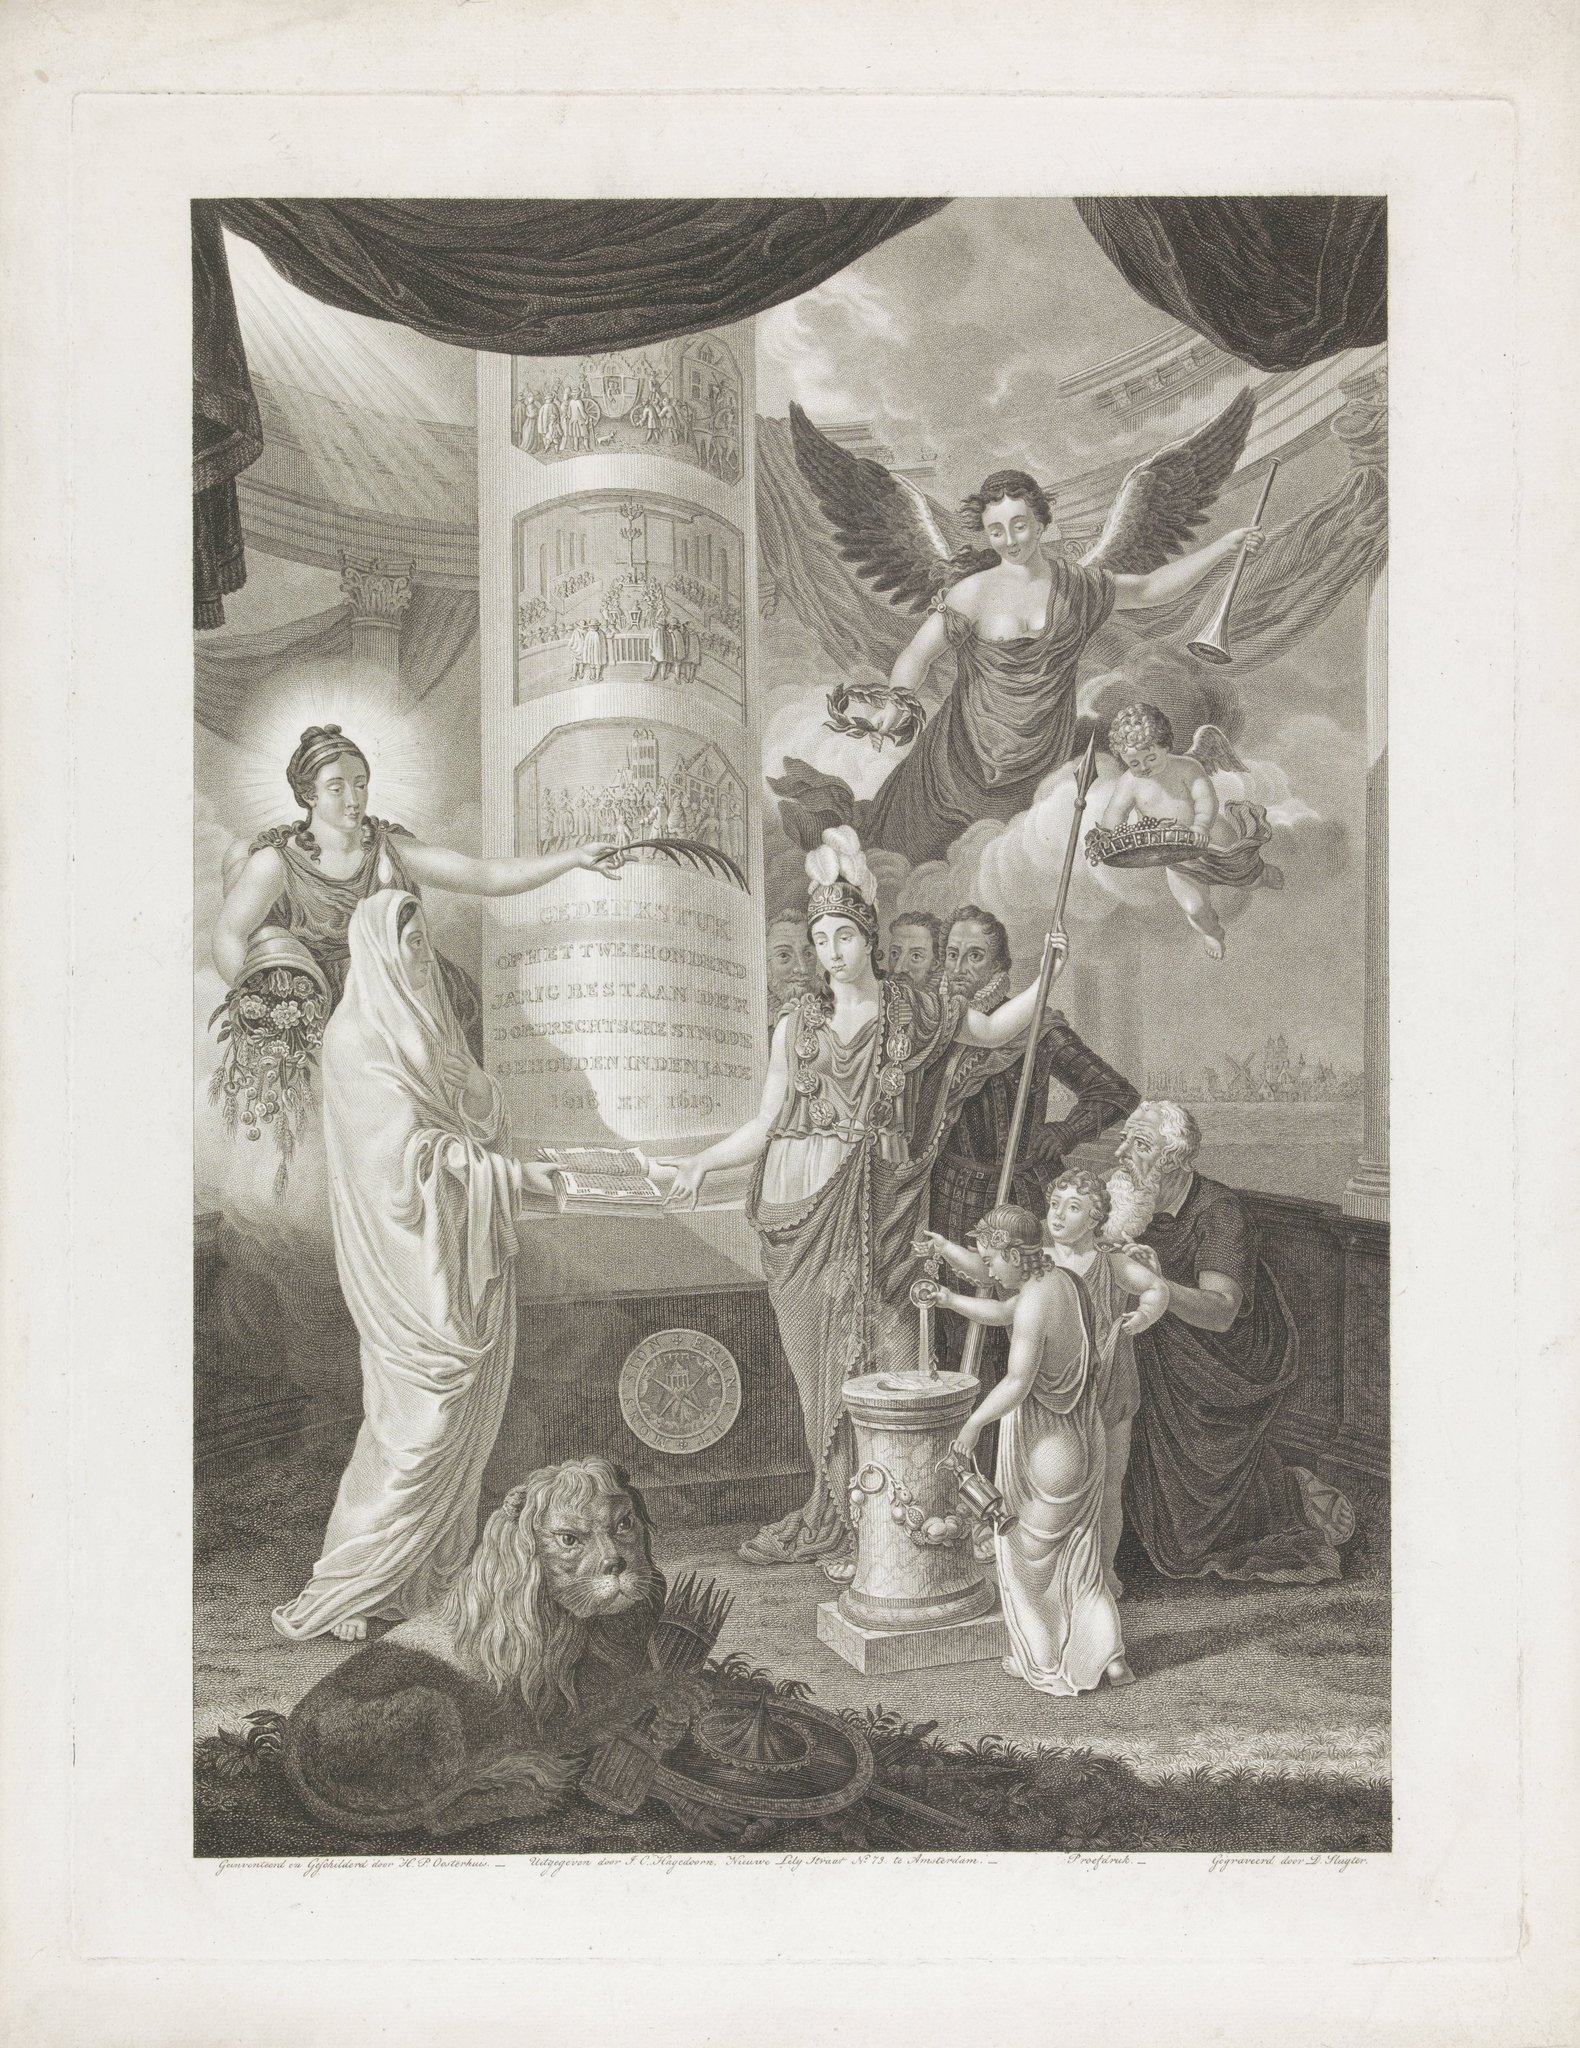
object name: print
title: Monument op tweede eeuwfeest van de Dordtse synode, 1818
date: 1818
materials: paper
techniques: engraving, etching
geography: amsterdam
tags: the hague, maurice (prince of orange), organizations, assemblies, etc. in protestant churches, personifications of countries, nations, states, districts, etc., symbols, allegories of peace, 'pax'; 'pace' (ripa), allegorical representations ~ religion; 'religione', 'religione de ss. mauritio e lazaro', 'religione vera christiana' (ripa), fame; 'fama', 'fama buona', 'fama chiara' (ripa), netherlands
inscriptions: collector's mark: Lugt 2228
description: Allegorisch monument ter ere van het tweede eeuwfeest in 1818 van de nationale synode van de gereformeerde kerk gehouden te Dordrecht van 13 november 1618 tot 29 mei 1619. Centraal in een tempel staat een zuil met afbeeldingen van de synode. Voor de zuil overhandigt de Godsdienst een Bijbel aan de Nederlandse Maagd. Achter de maagd staan enkele historische figuren, vooraan is prins Maurits te herkennen. Links de Vrede met een hoorn van overvloed en een palmtak, rechts knielt een grijsaard met enkele kinderen bij een altaar. In de wolken vliegt de Faam, op de voorgrond ligt de Nederlandse leeuw.